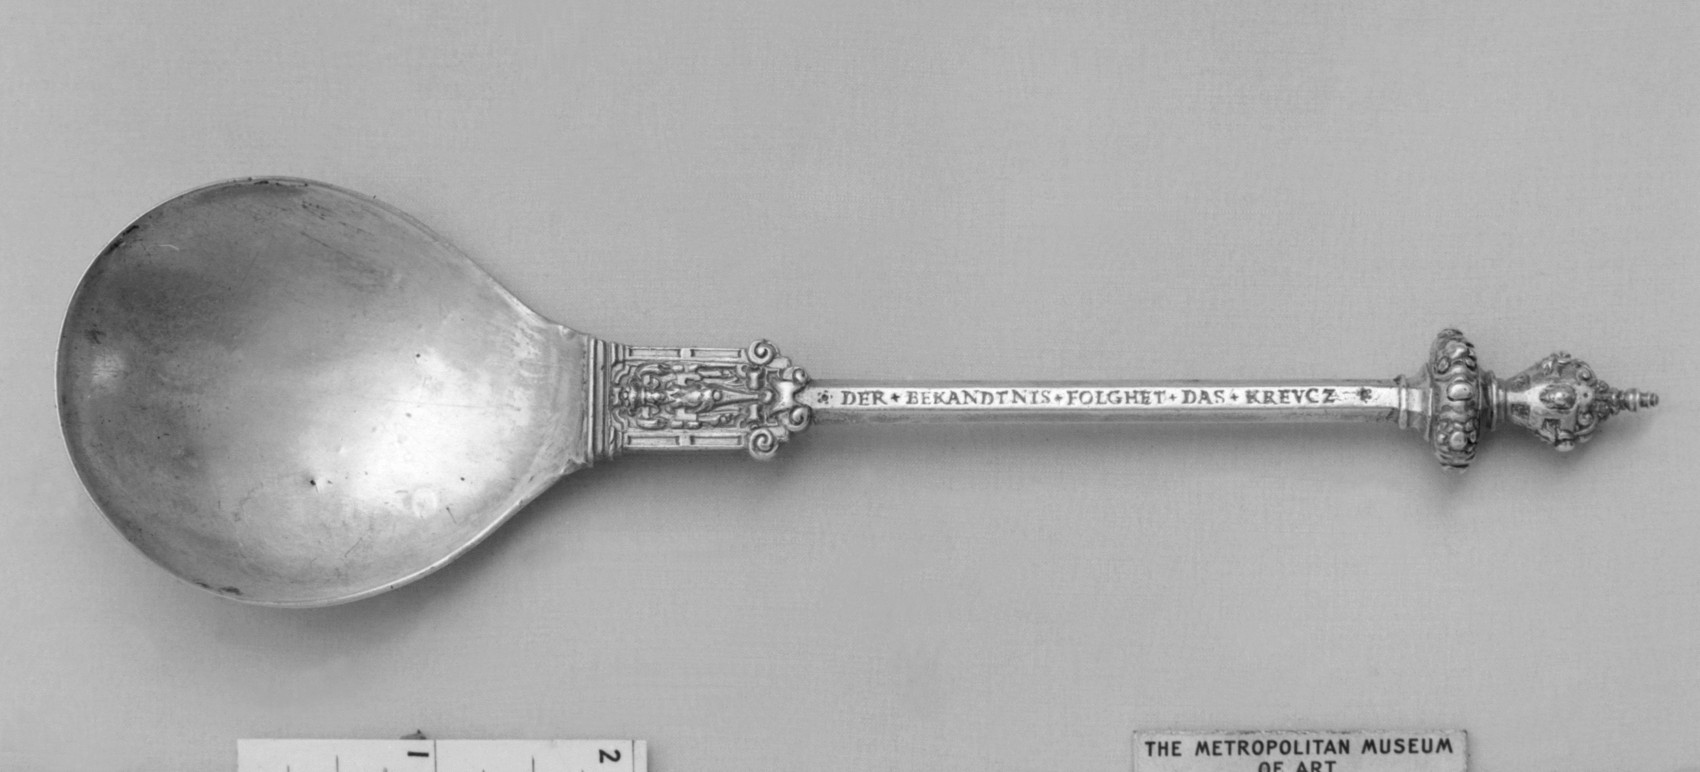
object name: spoon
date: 1567-1633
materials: gilt, silver